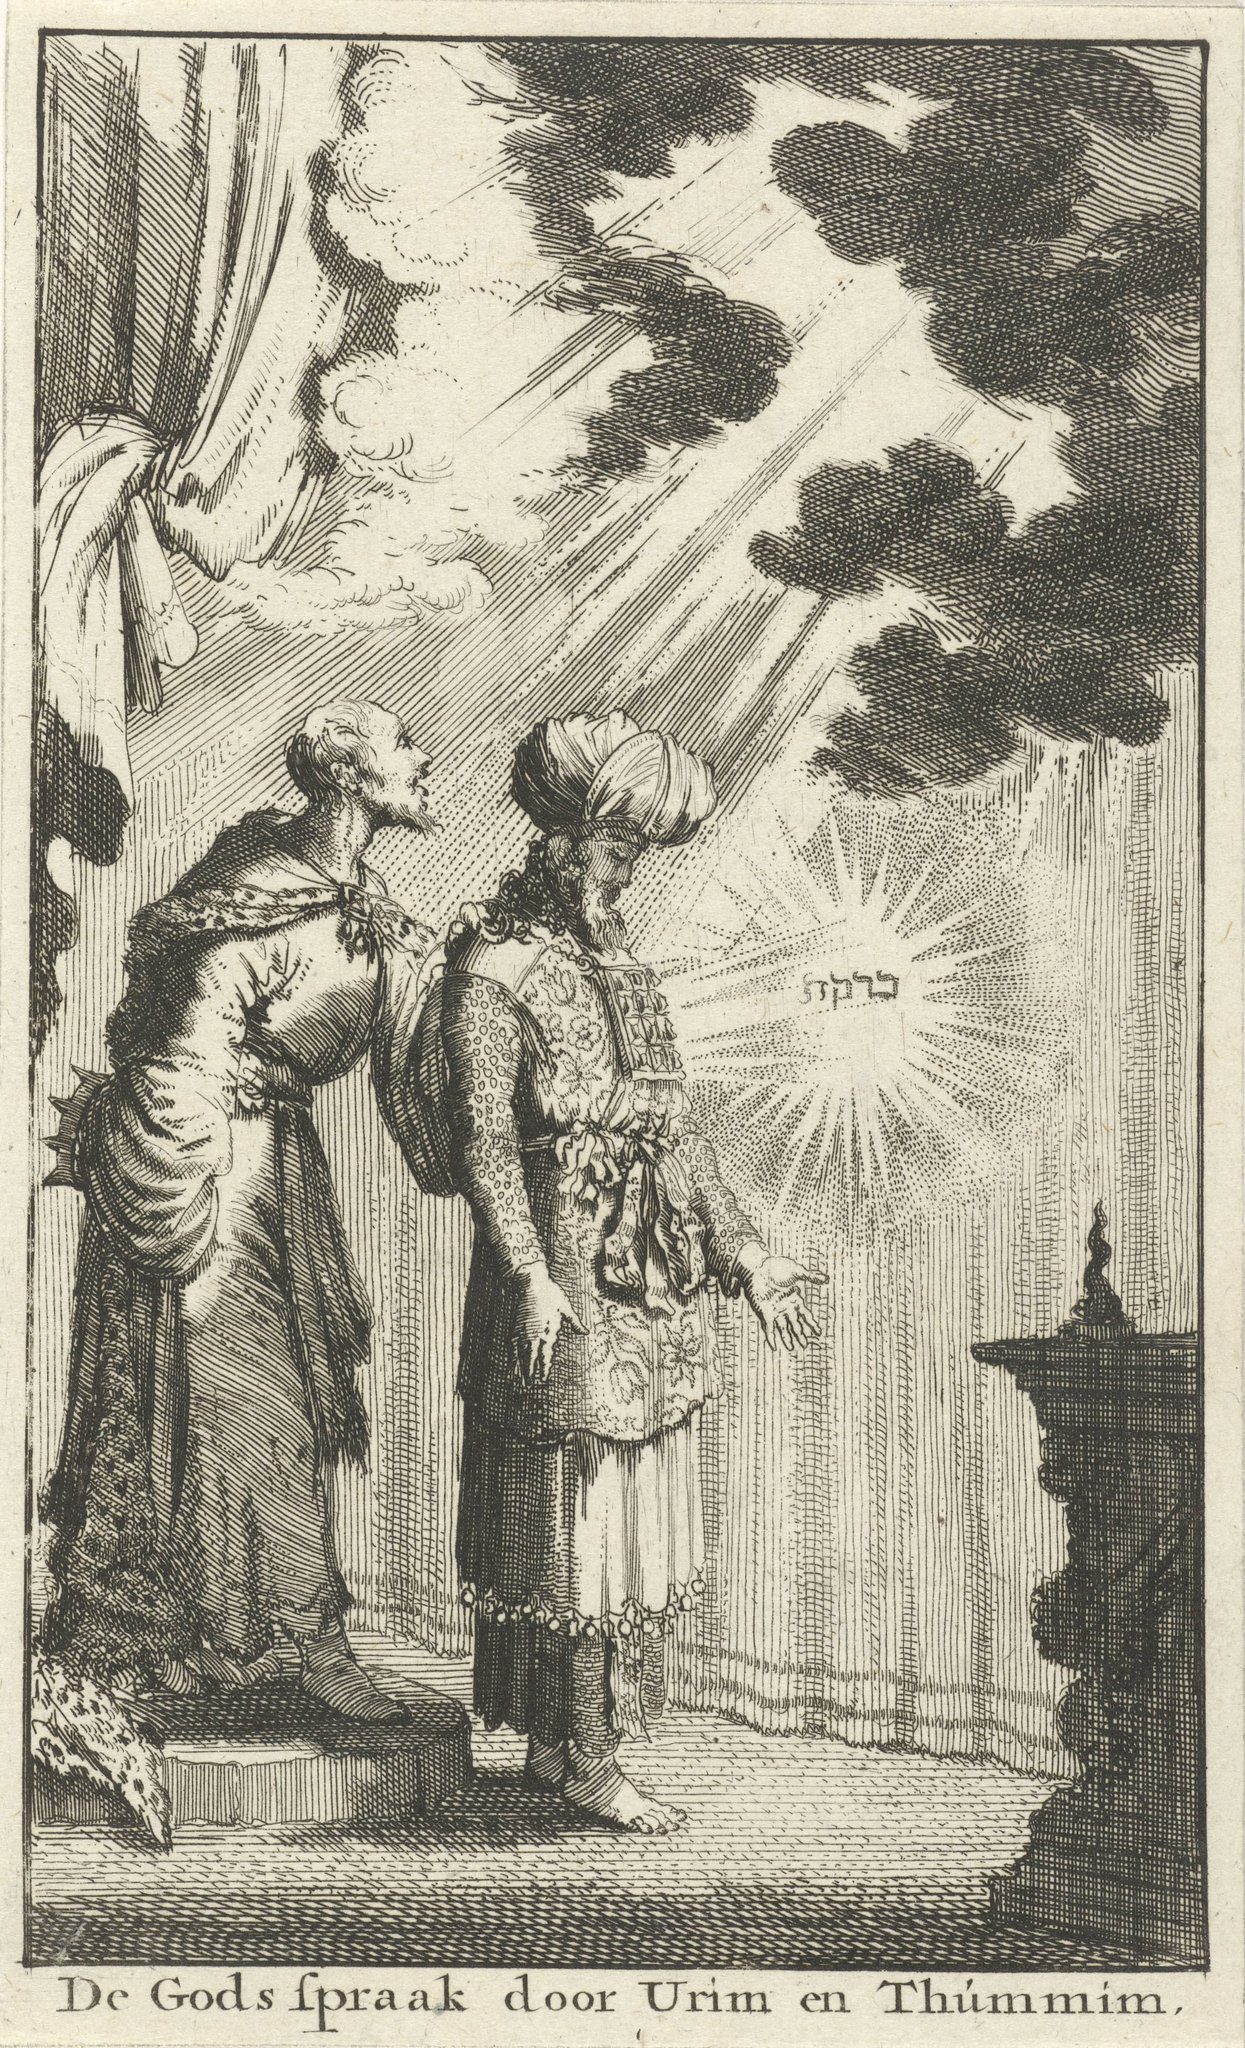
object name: book illustration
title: Godspraak door de Urim en de Thummim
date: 1682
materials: paper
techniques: etching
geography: amsterdam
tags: 'urim' and 'thummim' ~ vestments of high priest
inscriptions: collector's mark: Lugt 2228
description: Illustratie opgenomen in: Cunaeus, Petrus. De republyk der Hebreen, of gemeenebest der joden, 3 delen. Amsterdam: Wilhelmus Goeree, 1682, dl. 1, p. 174.